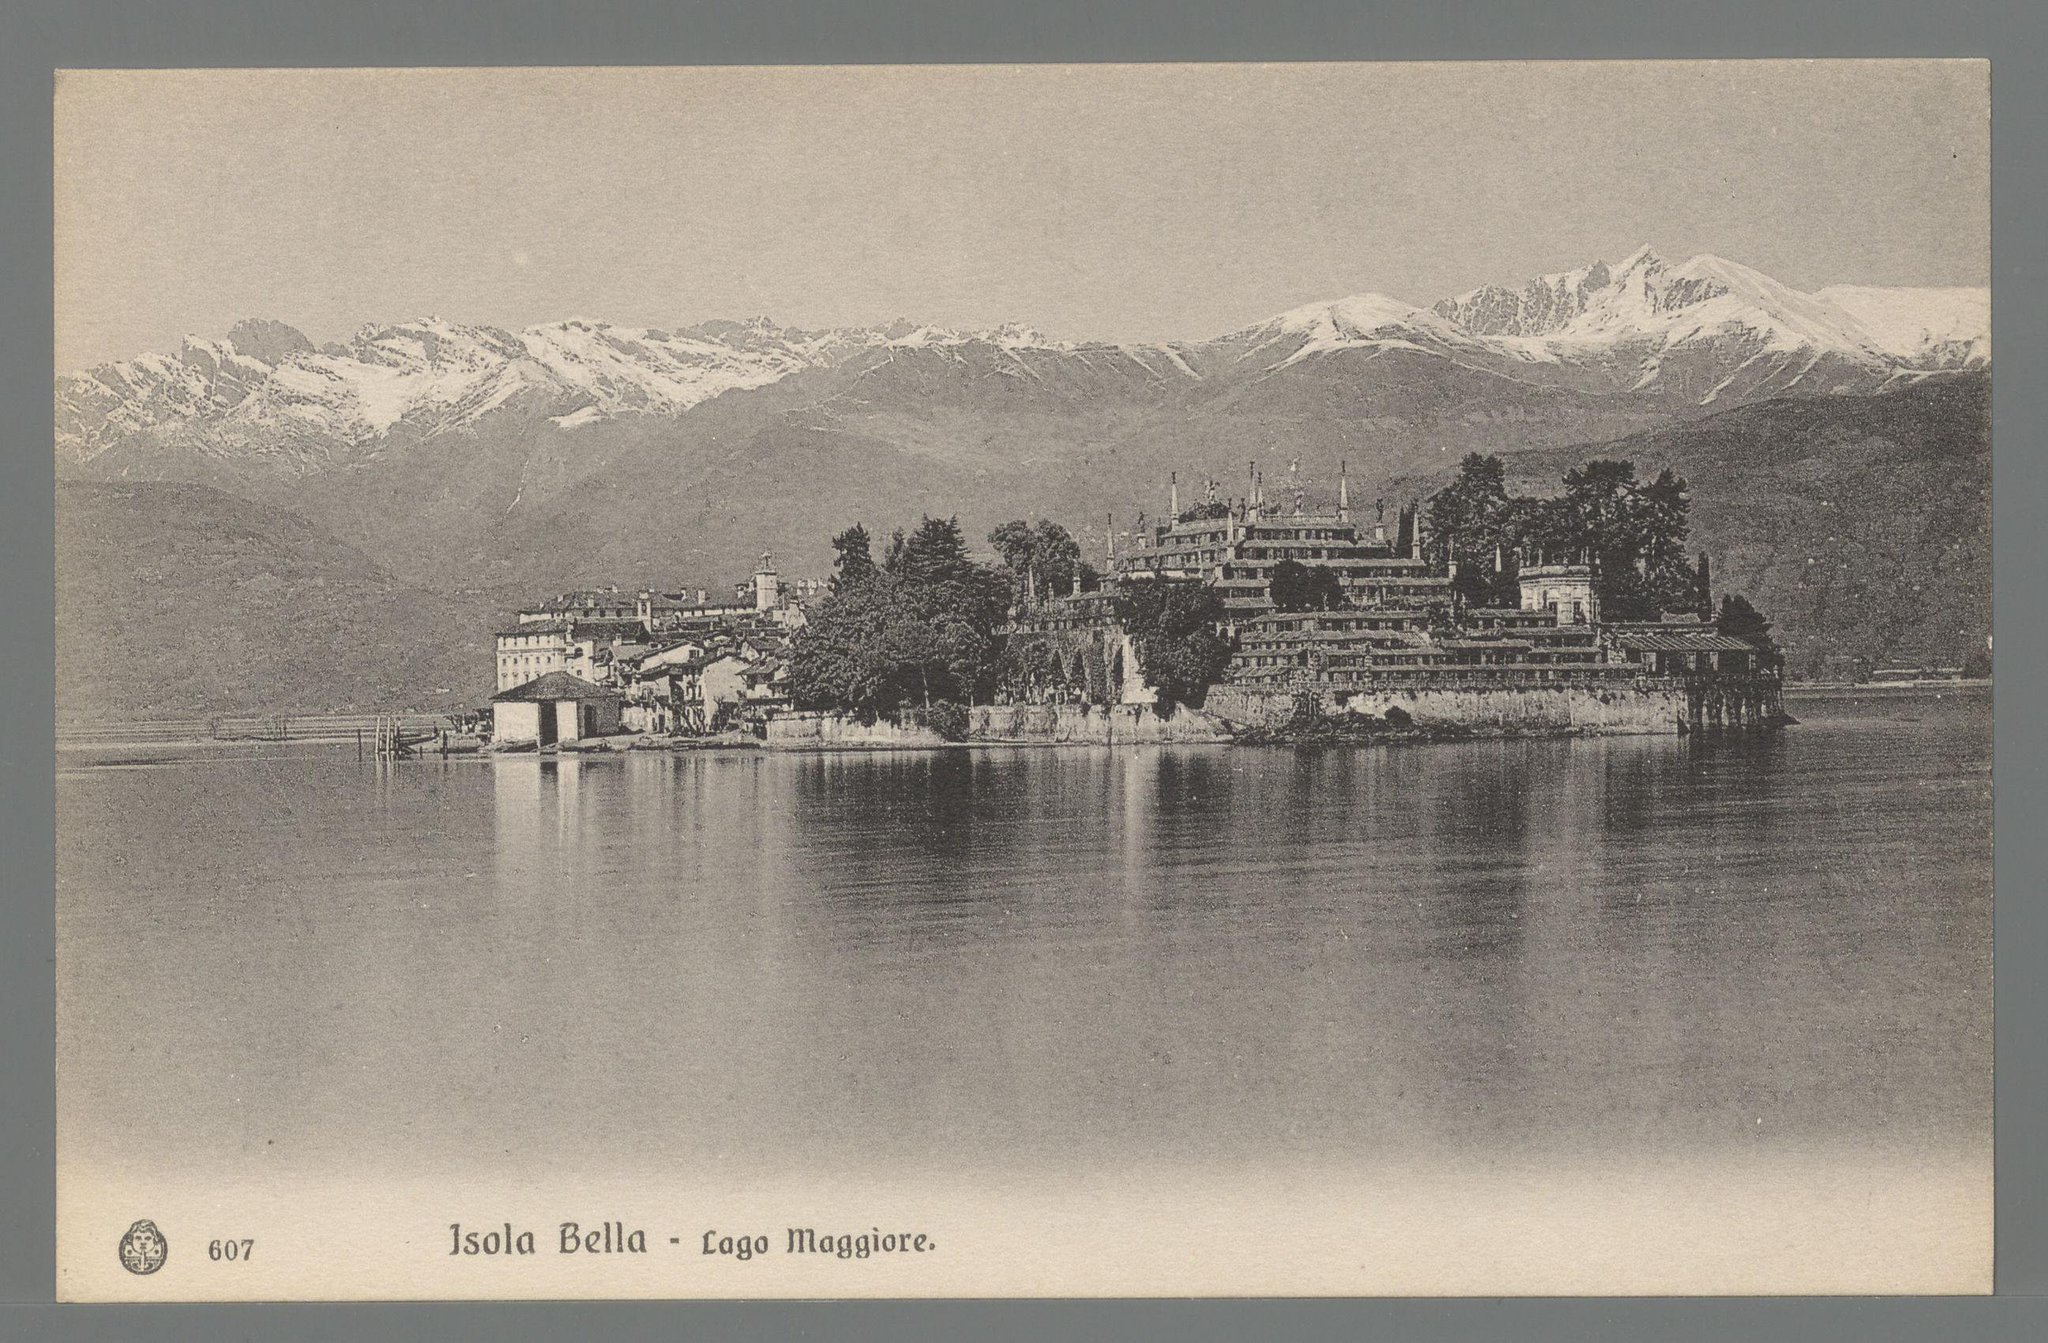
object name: ansichtkaart, prentbriefkaart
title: Isola Bella. Lago Maggiore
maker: Anonymous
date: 1905-1909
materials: cardboard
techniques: photograph, writing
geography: lake maggiore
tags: island, lake, mountains